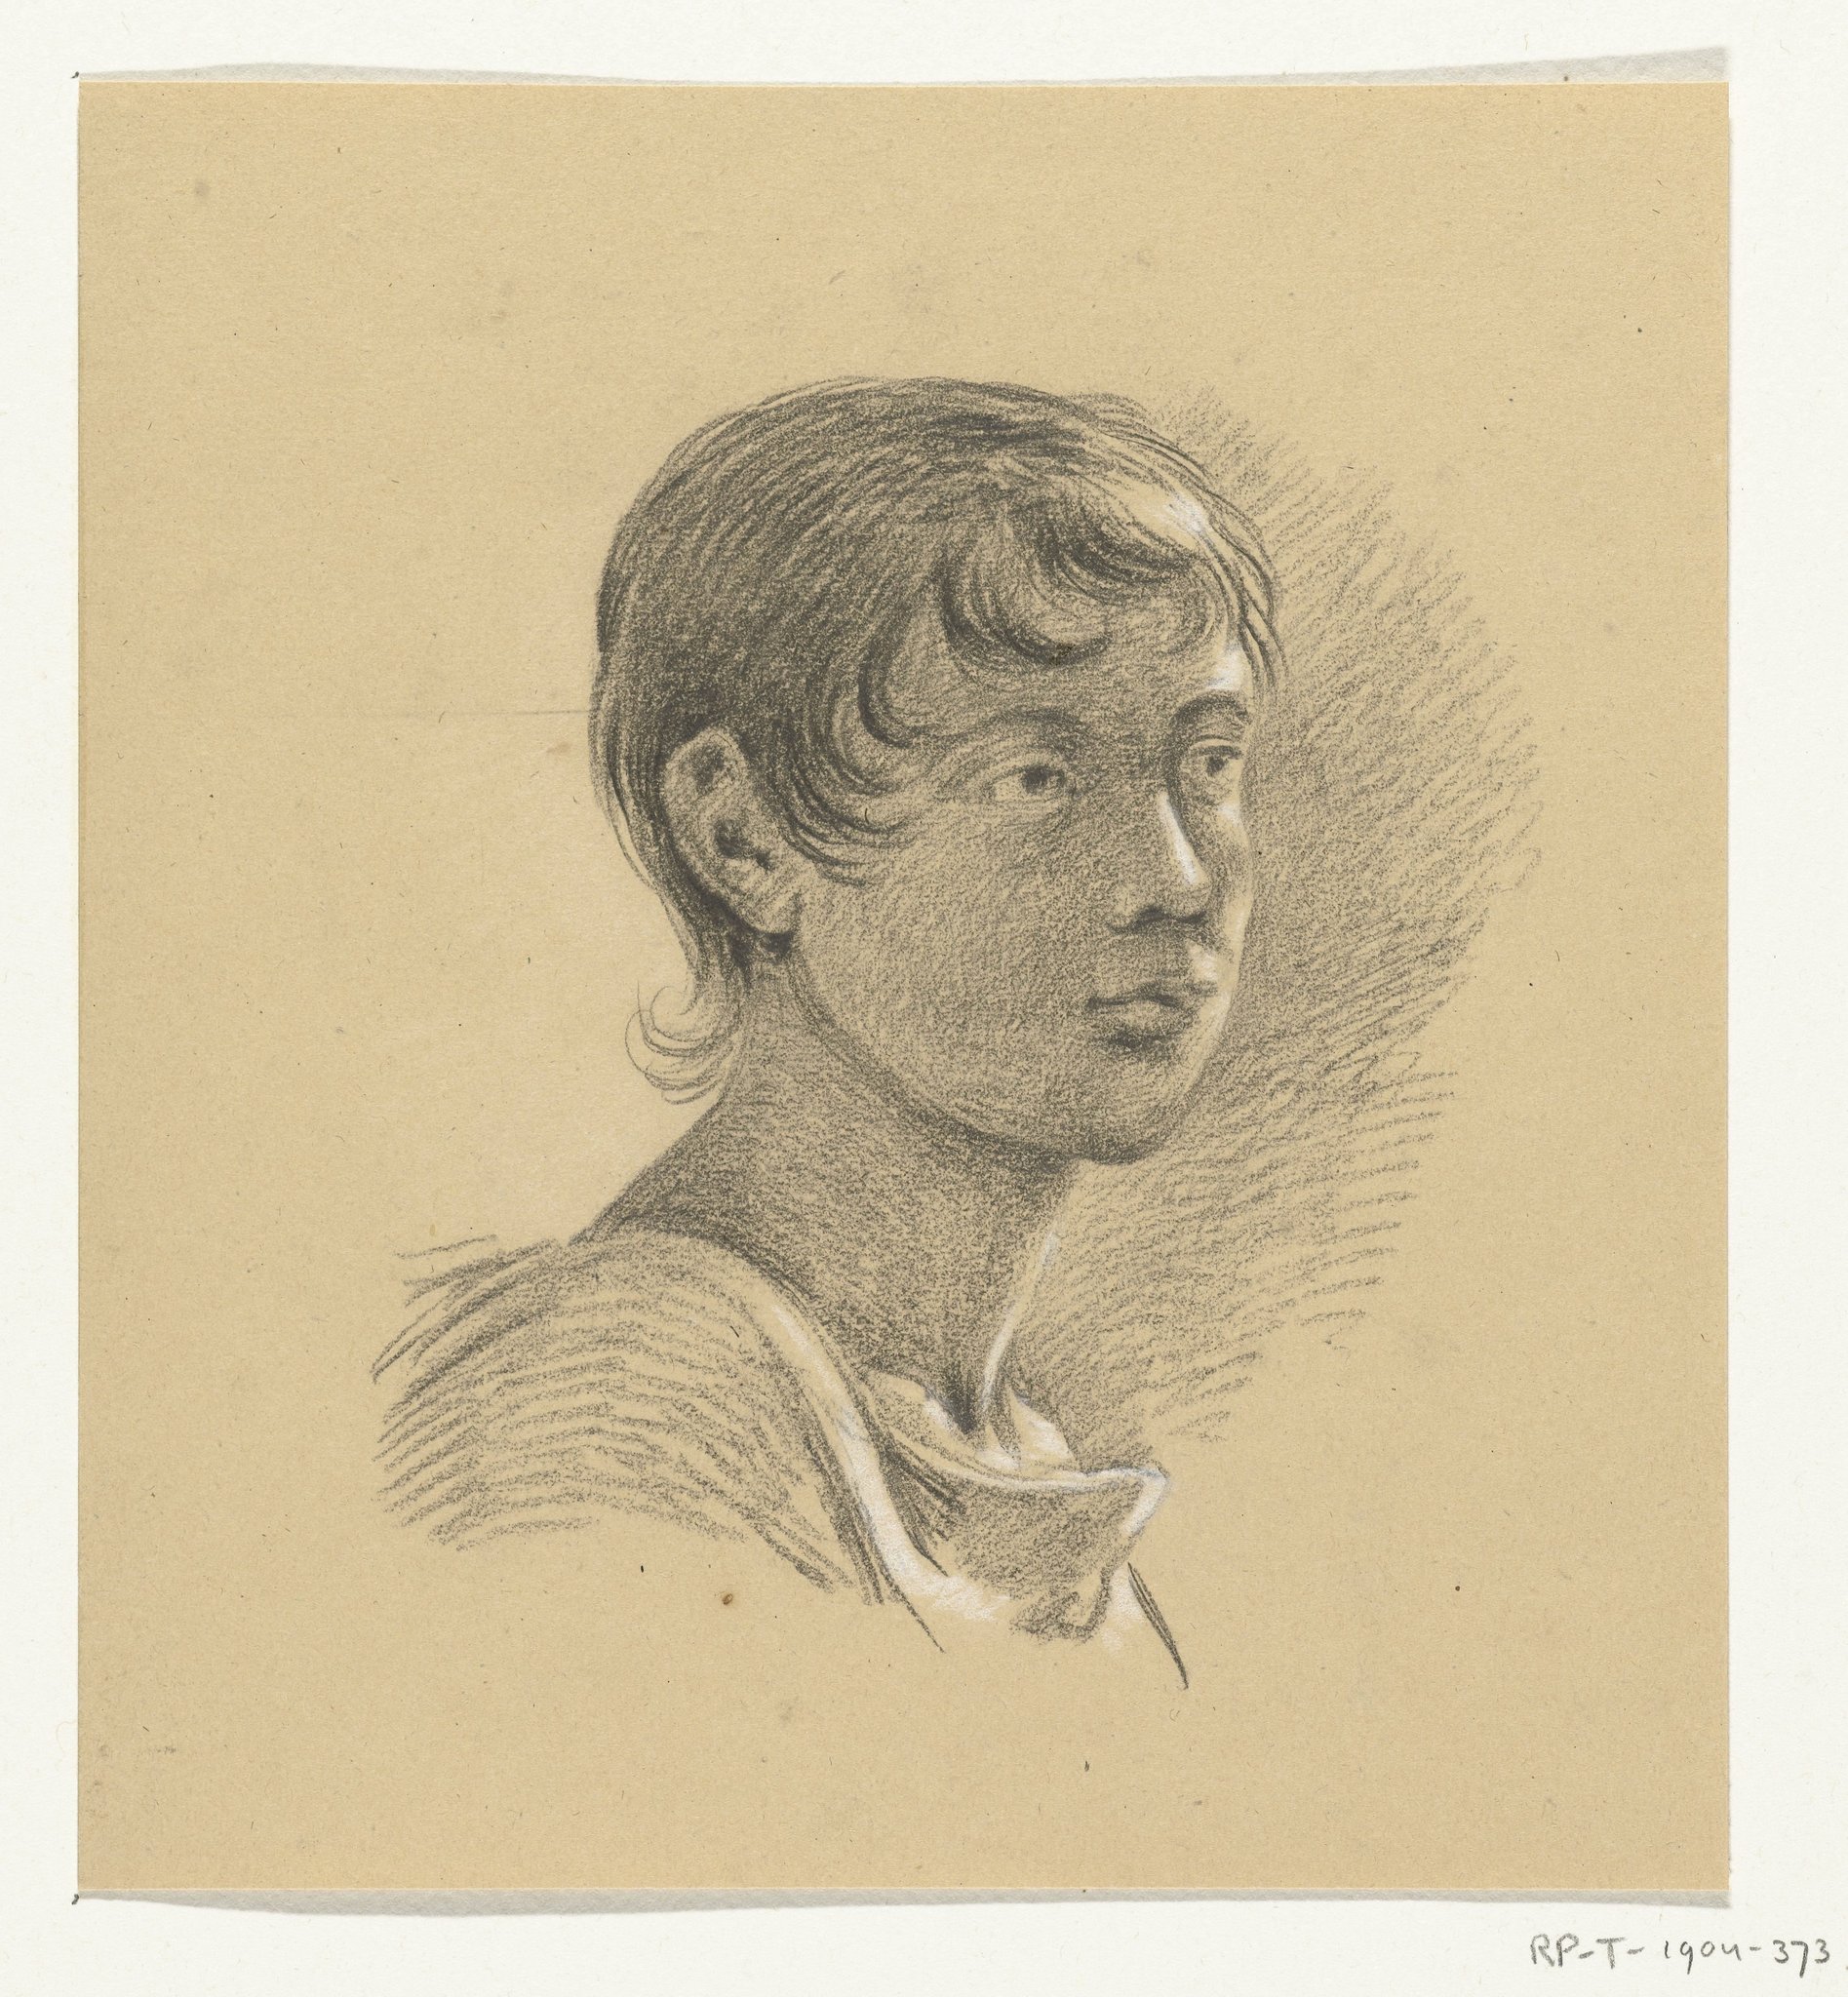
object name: drawing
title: Kop van een jongen, naar rechts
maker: jean bernard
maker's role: draughtsman, print maker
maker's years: 1765-1833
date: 1775-1833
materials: chalk, paper